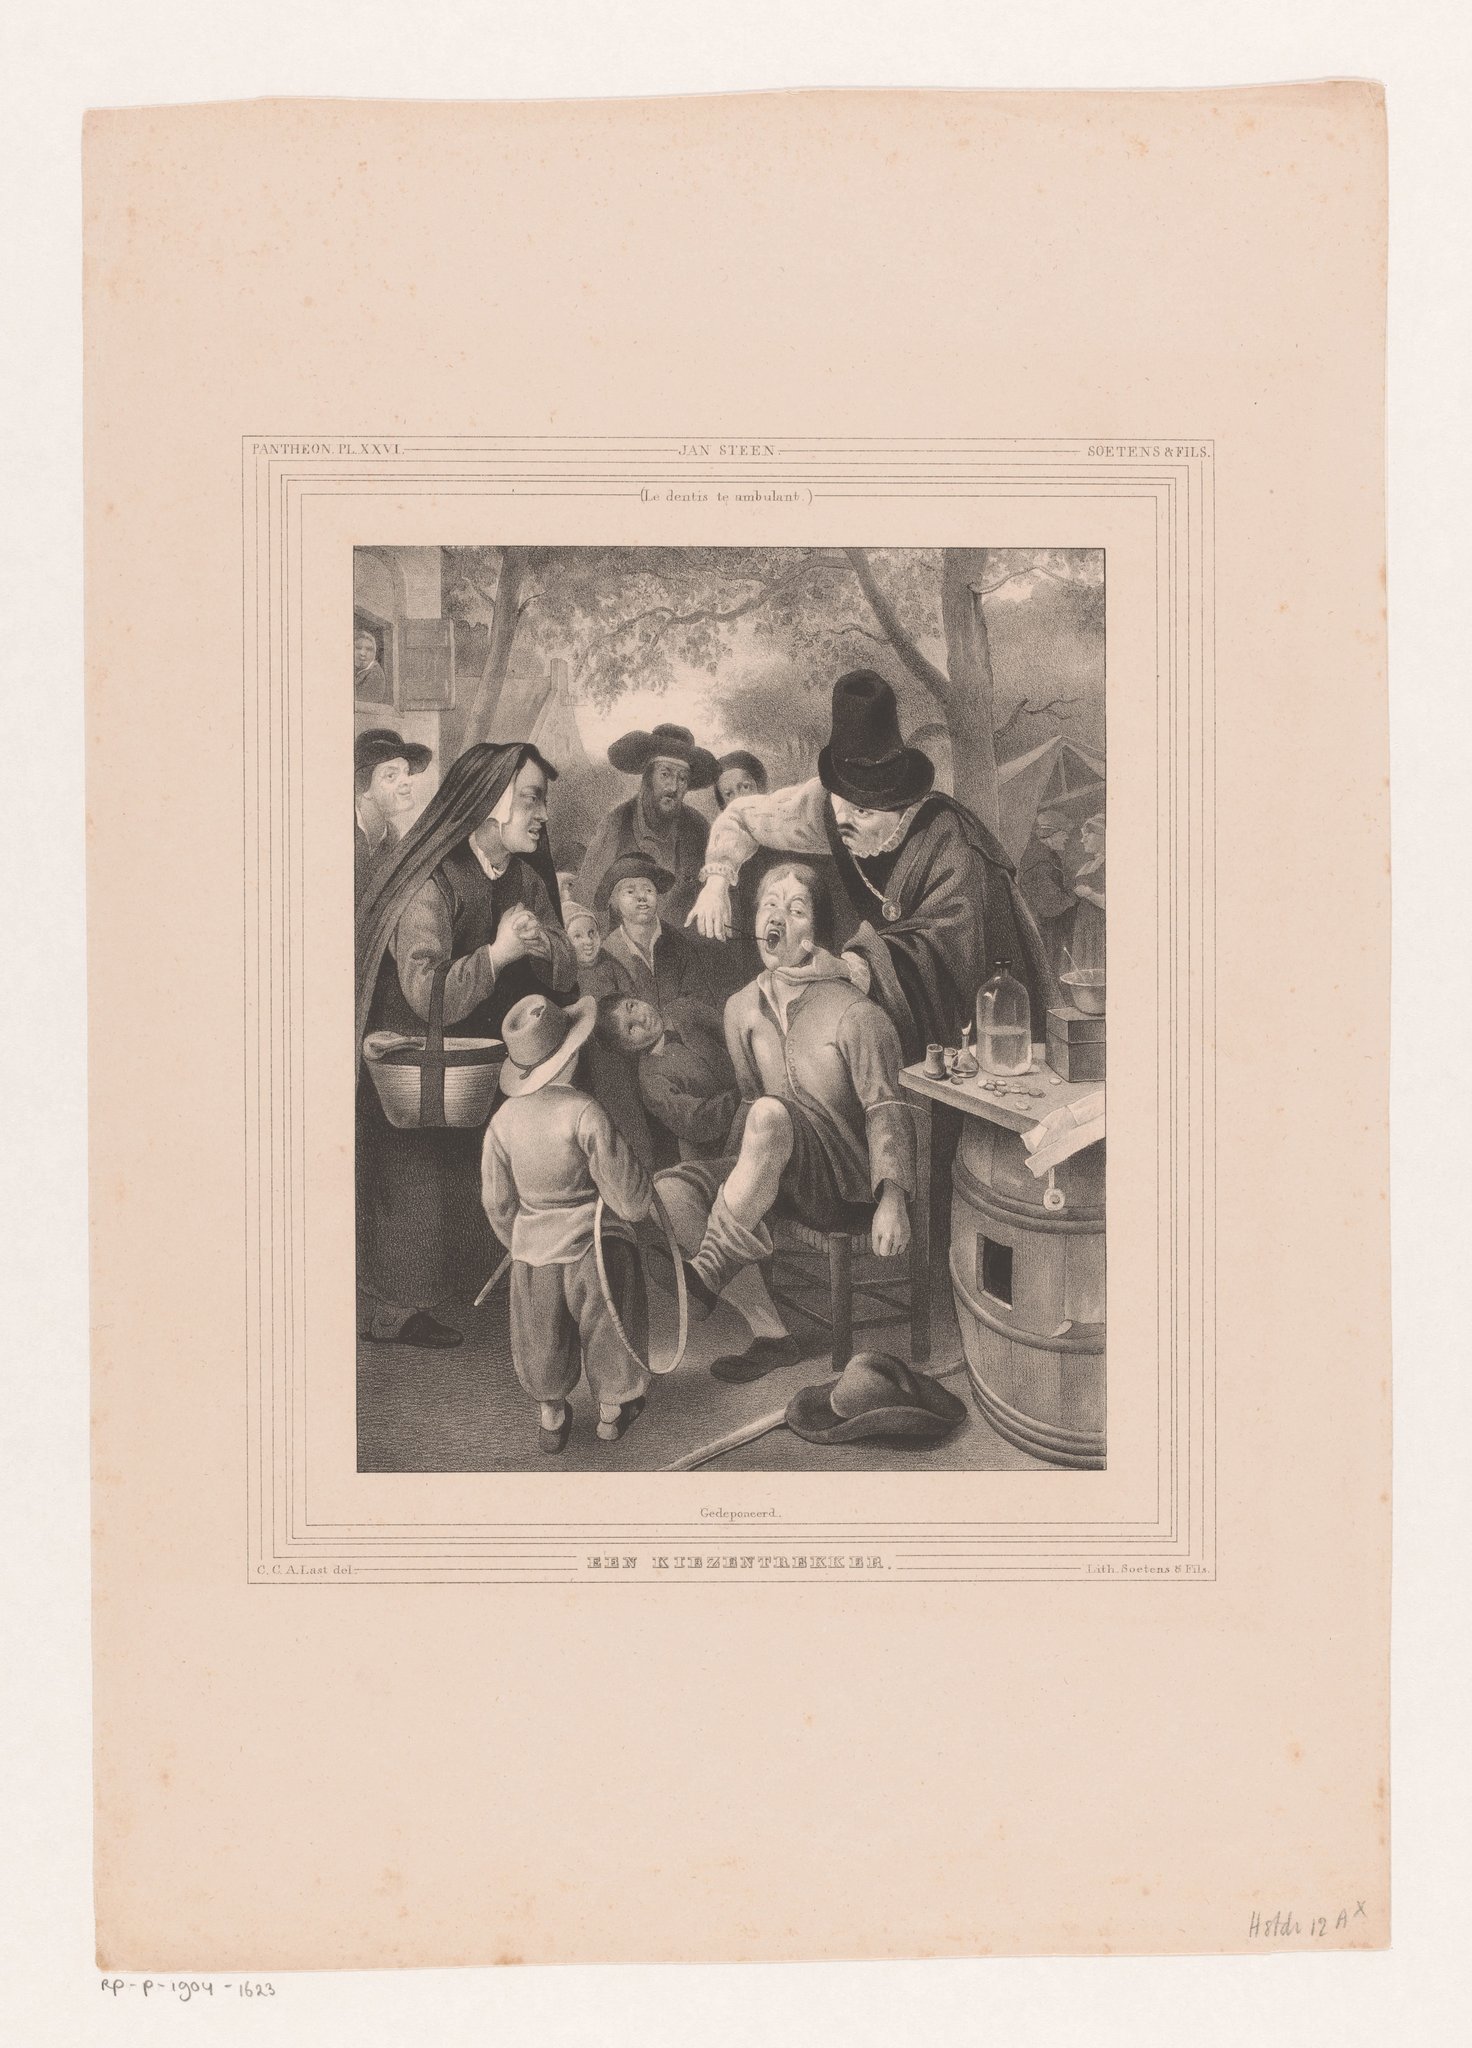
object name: print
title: Tandentrekker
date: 1837-1840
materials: paper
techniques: lithograph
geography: the hague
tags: (bowling a) hoop, (barber as) dentist, quack extracting teeth or molars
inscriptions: collector's mark: Lugt 2228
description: De patiënt zit vastgebonden op een stoel. De kwakzalver staat achter hem en trekt met een tang een tand uit zijn mond. Om hen heen staan toeschouwers. In de voorgrond een jongen op de rug gezien met een hoepel onder zijn arm. Genummerd linksboven: Pantheon Pl. XXVI.